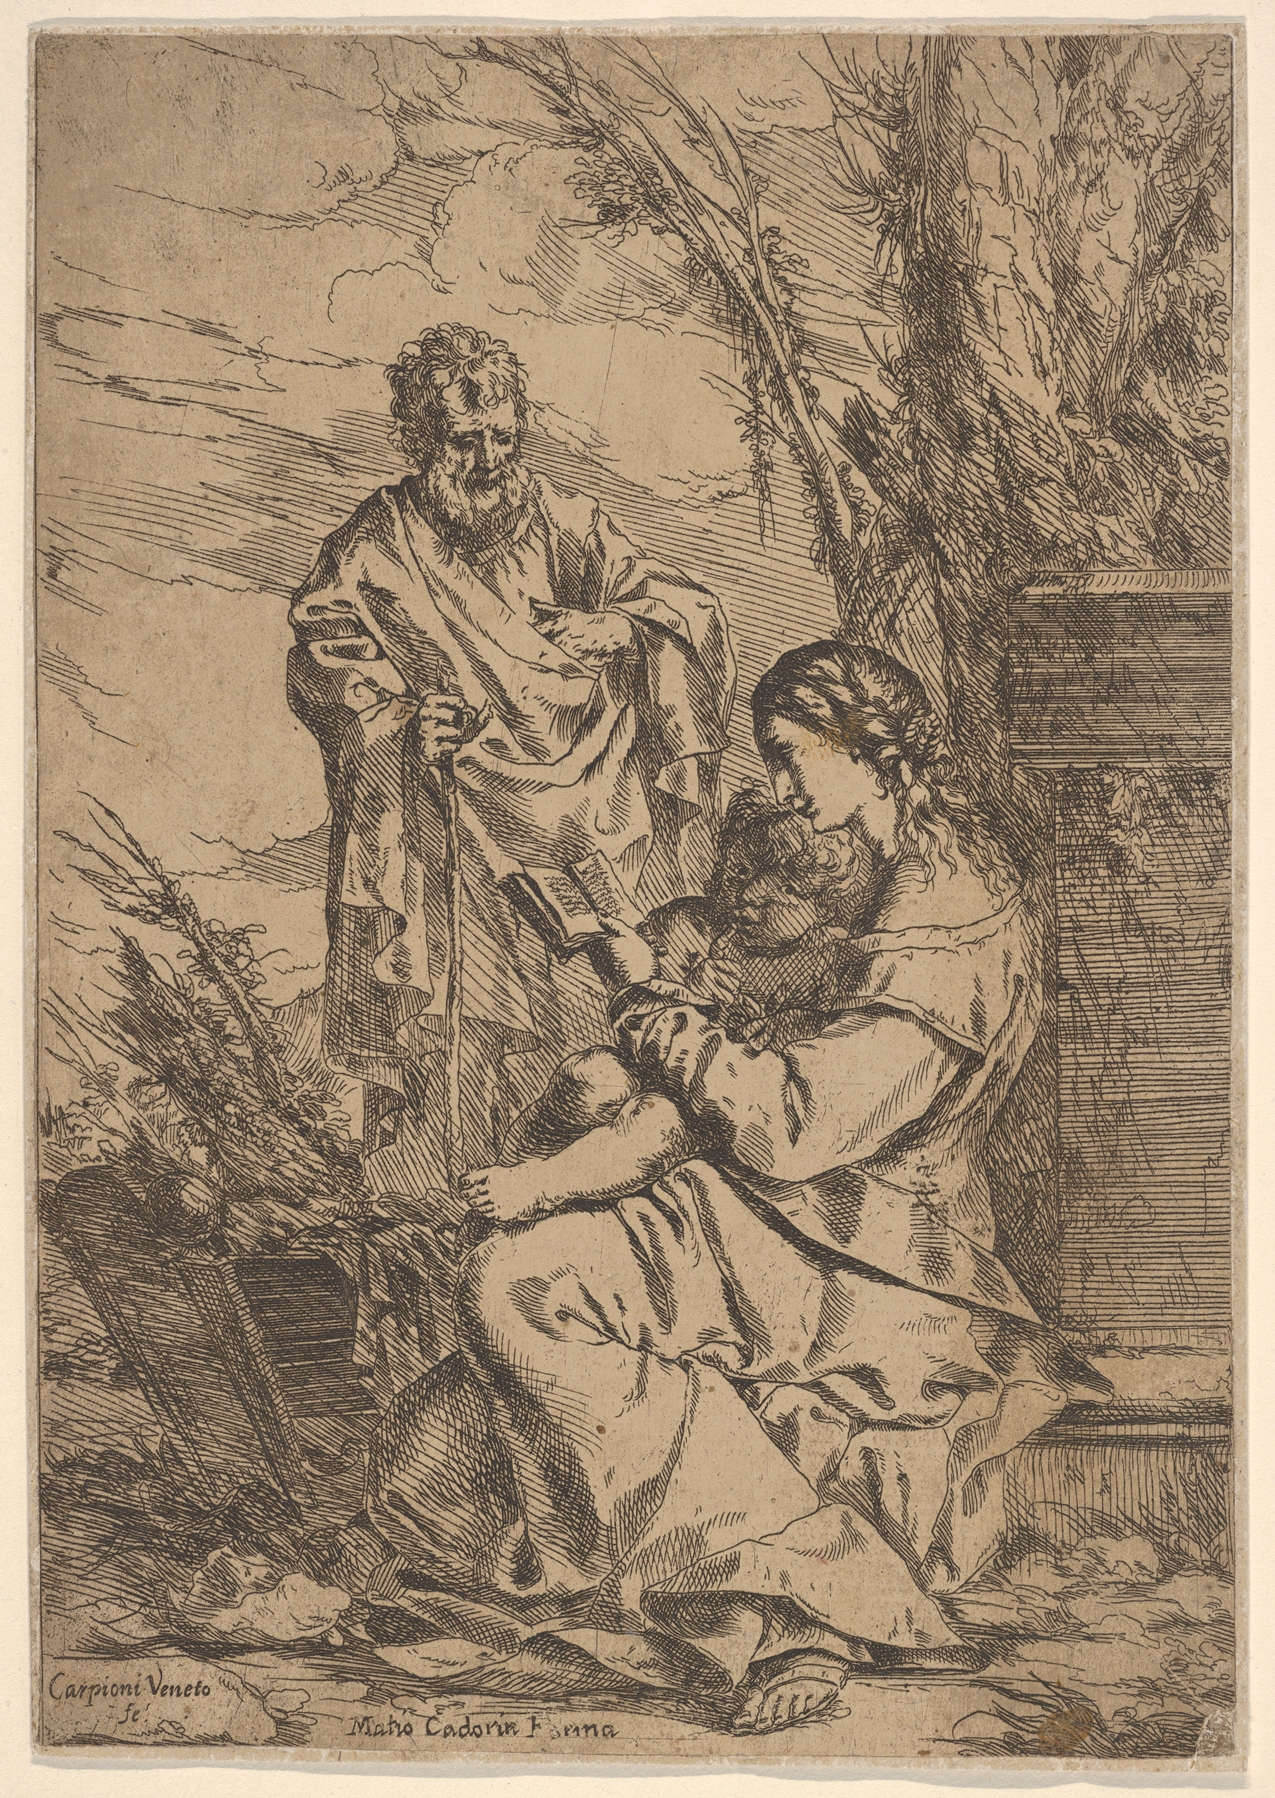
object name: print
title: Holy Family with the Virgin reading, the Virgin sits in profile with a book in her left hand and the Child facing the viewer, Joseph stands behind them with a staff in his right hand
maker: giulio carpioni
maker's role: artist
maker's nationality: italian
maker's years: 1613-1678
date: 1640-1660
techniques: etching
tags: books,reading,holy family,virgin mary,jesus